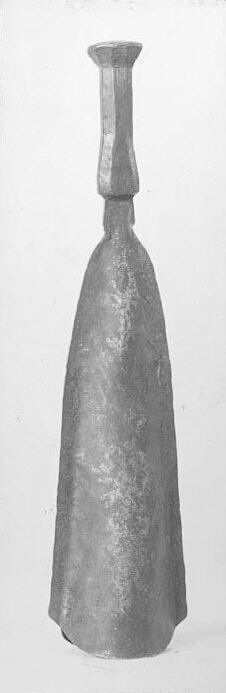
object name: bell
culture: congolese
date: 1867-1900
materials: iron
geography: democratic republic of the congo